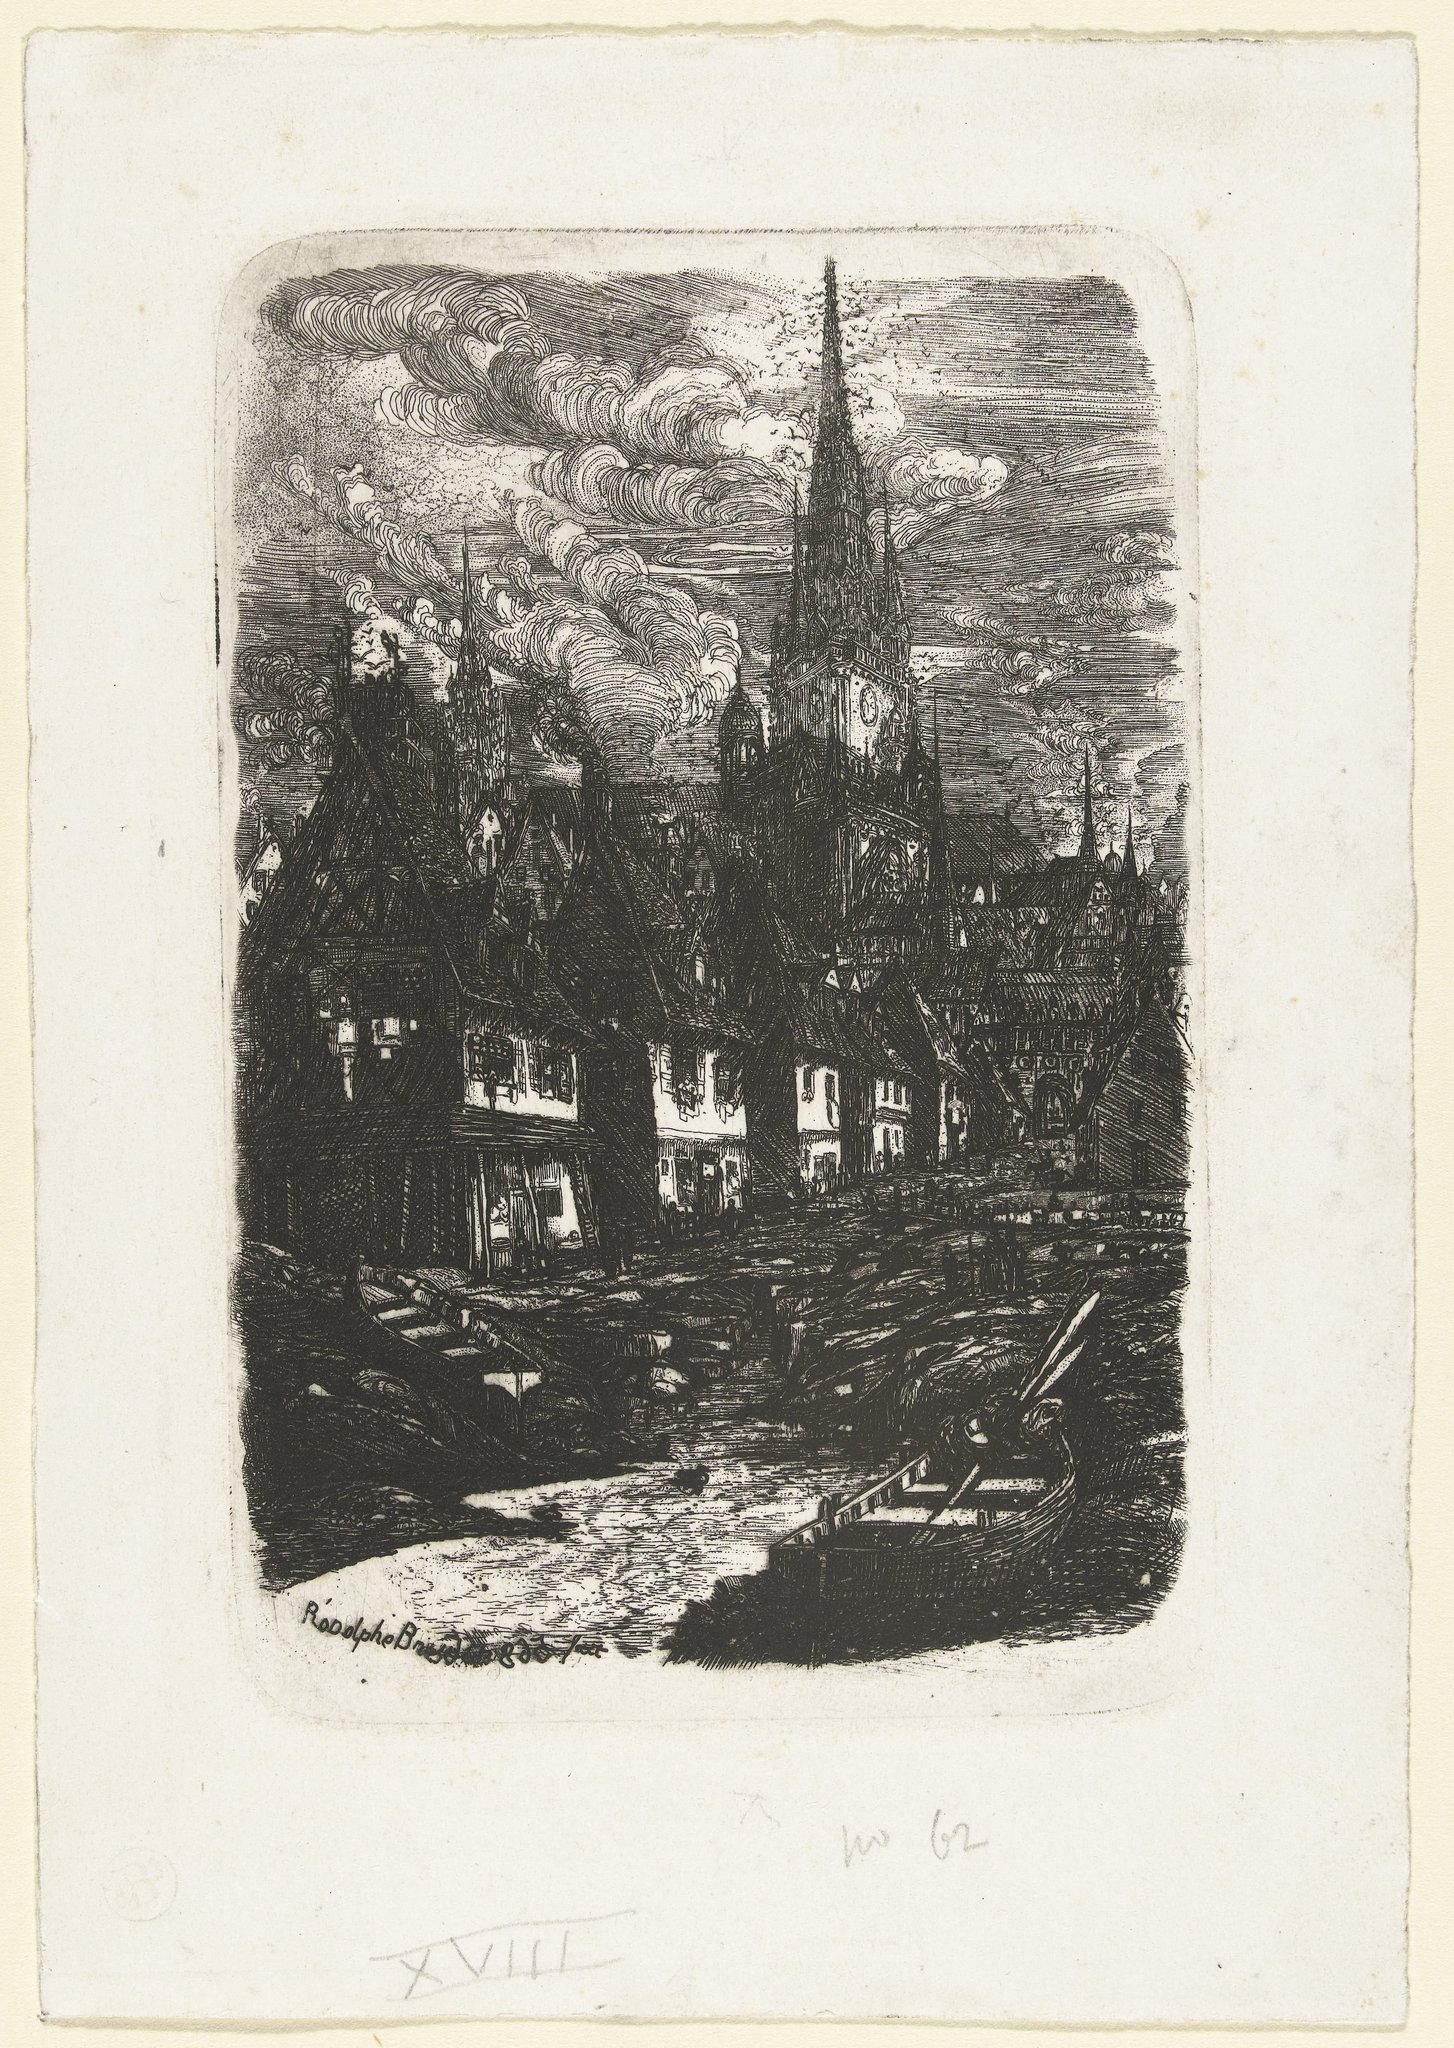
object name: print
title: Le port de pêche au clocher pointu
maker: rodolphe bresdin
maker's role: draughtsman, print maker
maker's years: 1822-1885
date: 1865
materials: paper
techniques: etching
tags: harbour, prospect of city, town panorama, silhouette of city, public road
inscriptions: collector's mark: Lugt 1989a, collector's mark: Lugt 2760, collector's mark: Lugt 2760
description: Stadsgezicht met op de voorgrond vissersboten op de oever en een rij vakwerkhuizen in een straat met aan het eind een stadspoort. Een kerktoren steekt hoog boven de daken uit.